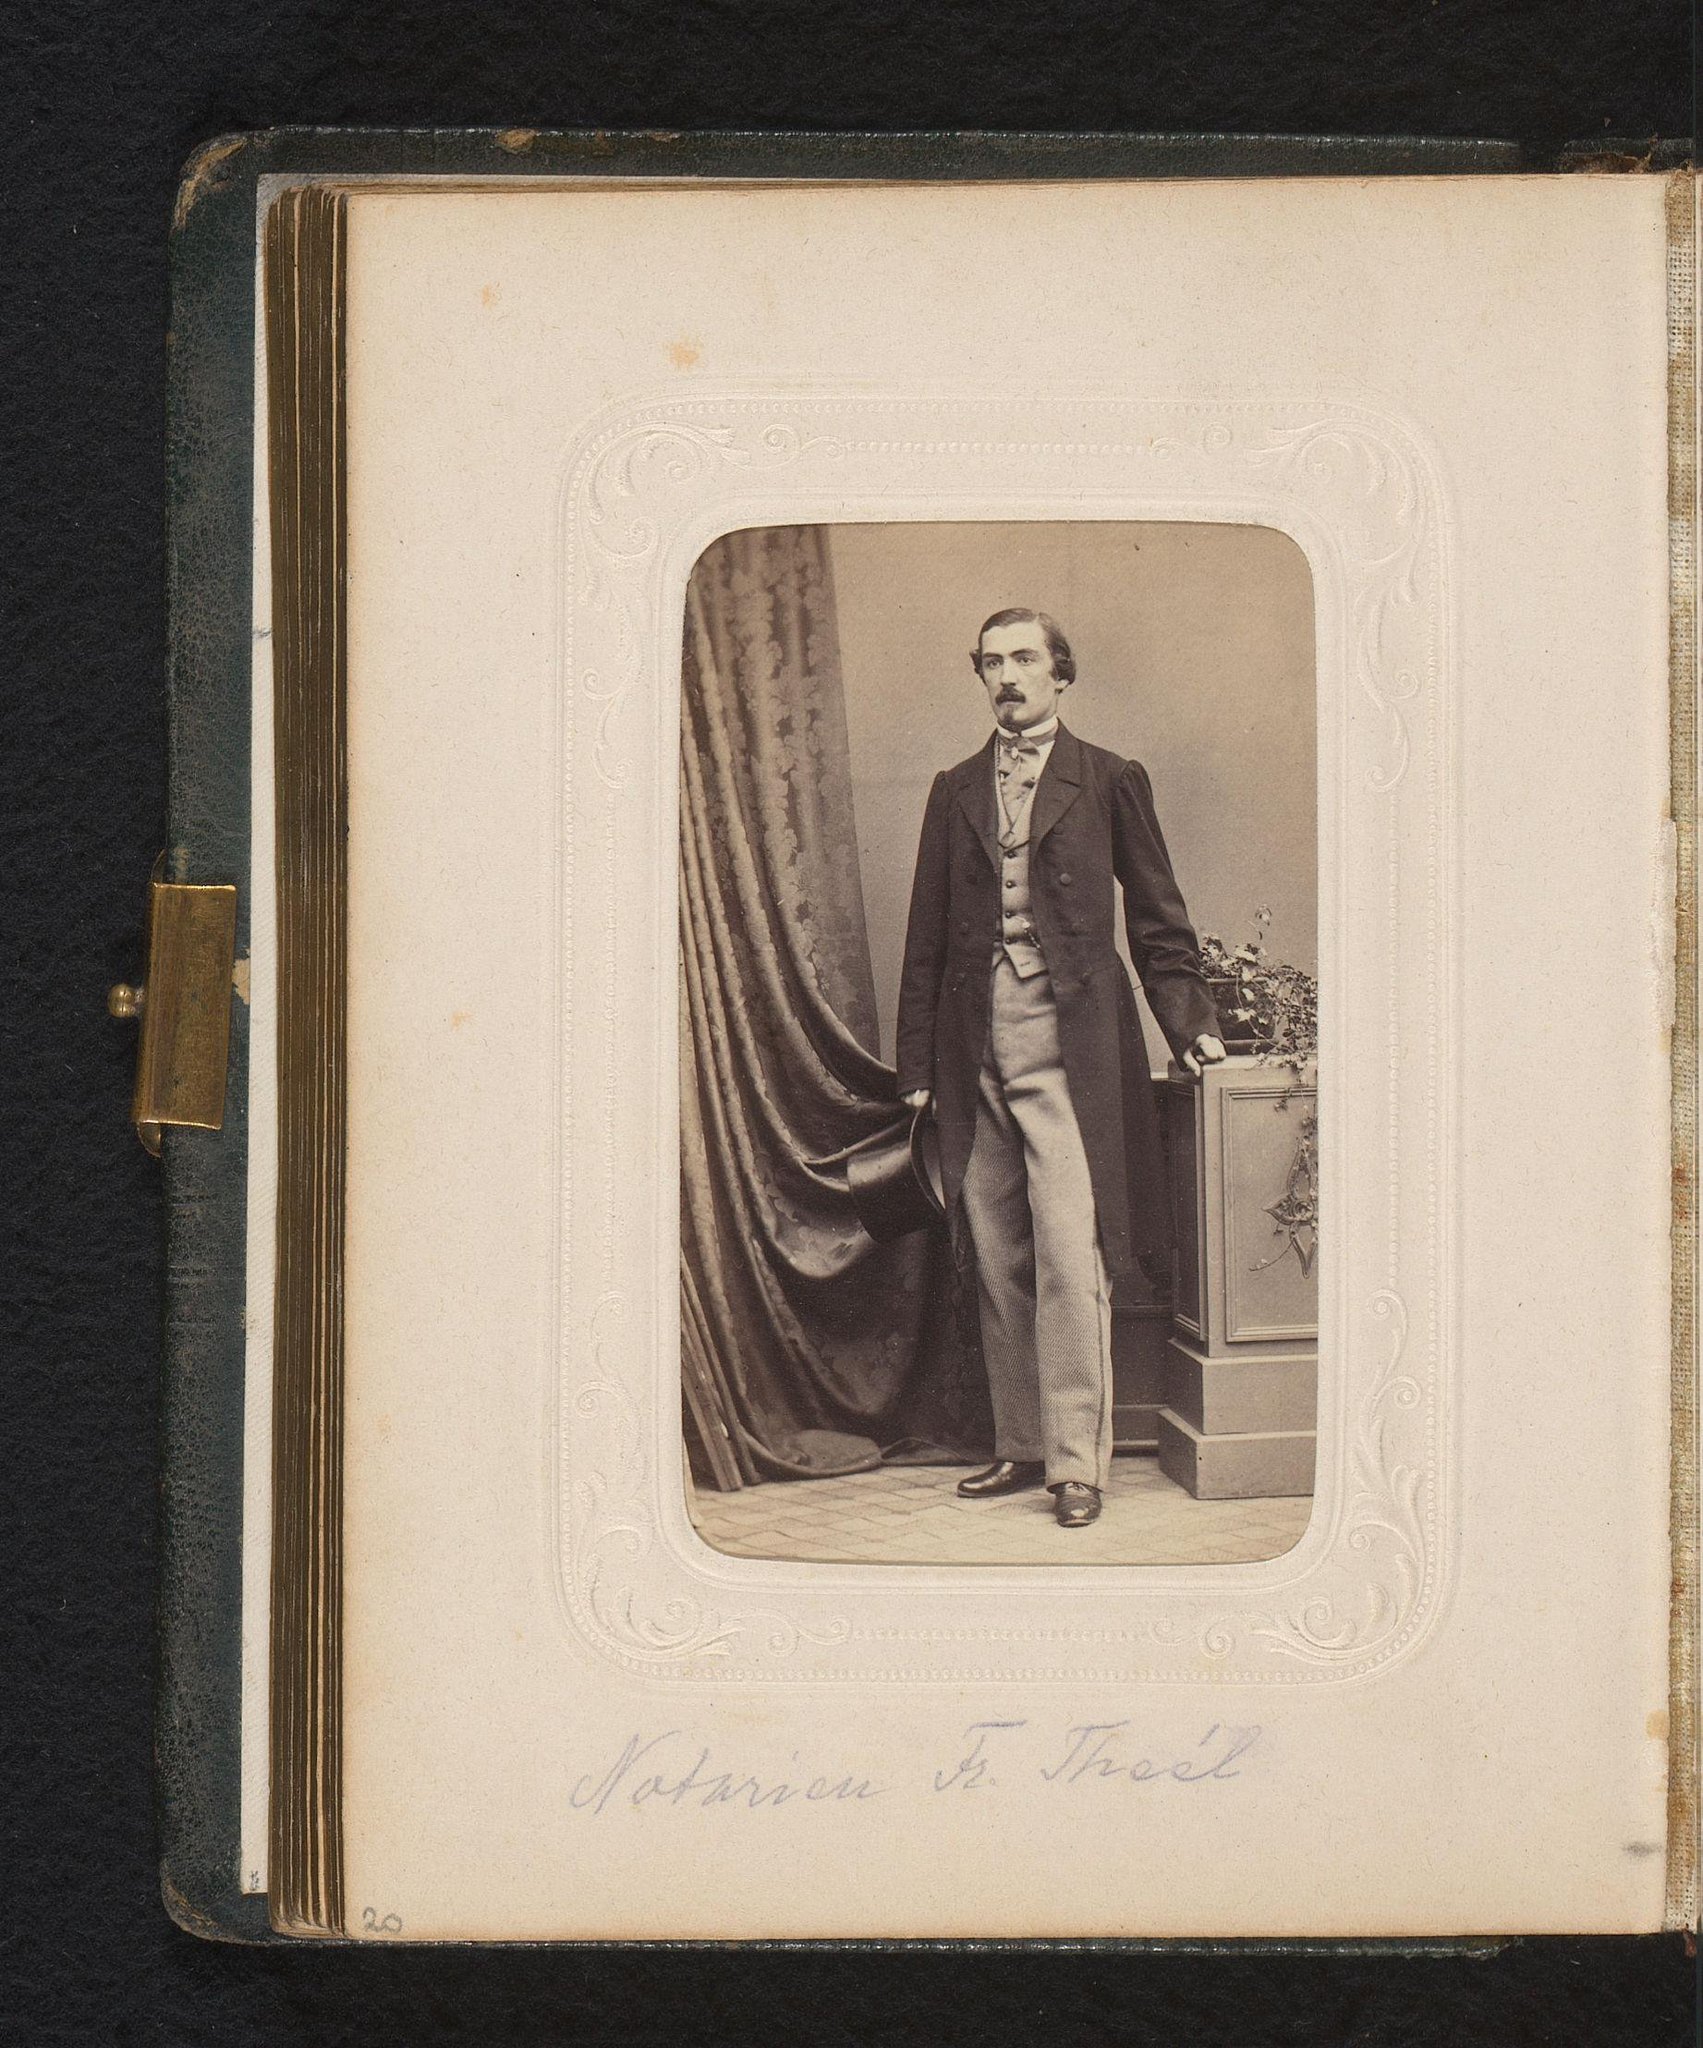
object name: album leaf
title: Portret van een staande man met hoge hoed in de hand, aangeduid als Natarier of Natarien Fr. Théel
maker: carl jacob malmberg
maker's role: fotograaf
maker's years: 1824-1895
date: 1860-1895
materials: cardboard, photographic support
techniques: albumen print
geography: stockholm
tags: standing figure, historical persons, head-gear: top hat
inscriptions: name: ‘Auditoren Kusse’, name: ‘F. Théel’, name: ‘Natarier Fr. Théel/ Död’, name: ‘Natarien Fr. Théel’, inscription: ‘C.J. MALMBERG/ PHOTOGRAF/ 42 Drottninggatan 42./ STOCKHOLM.’